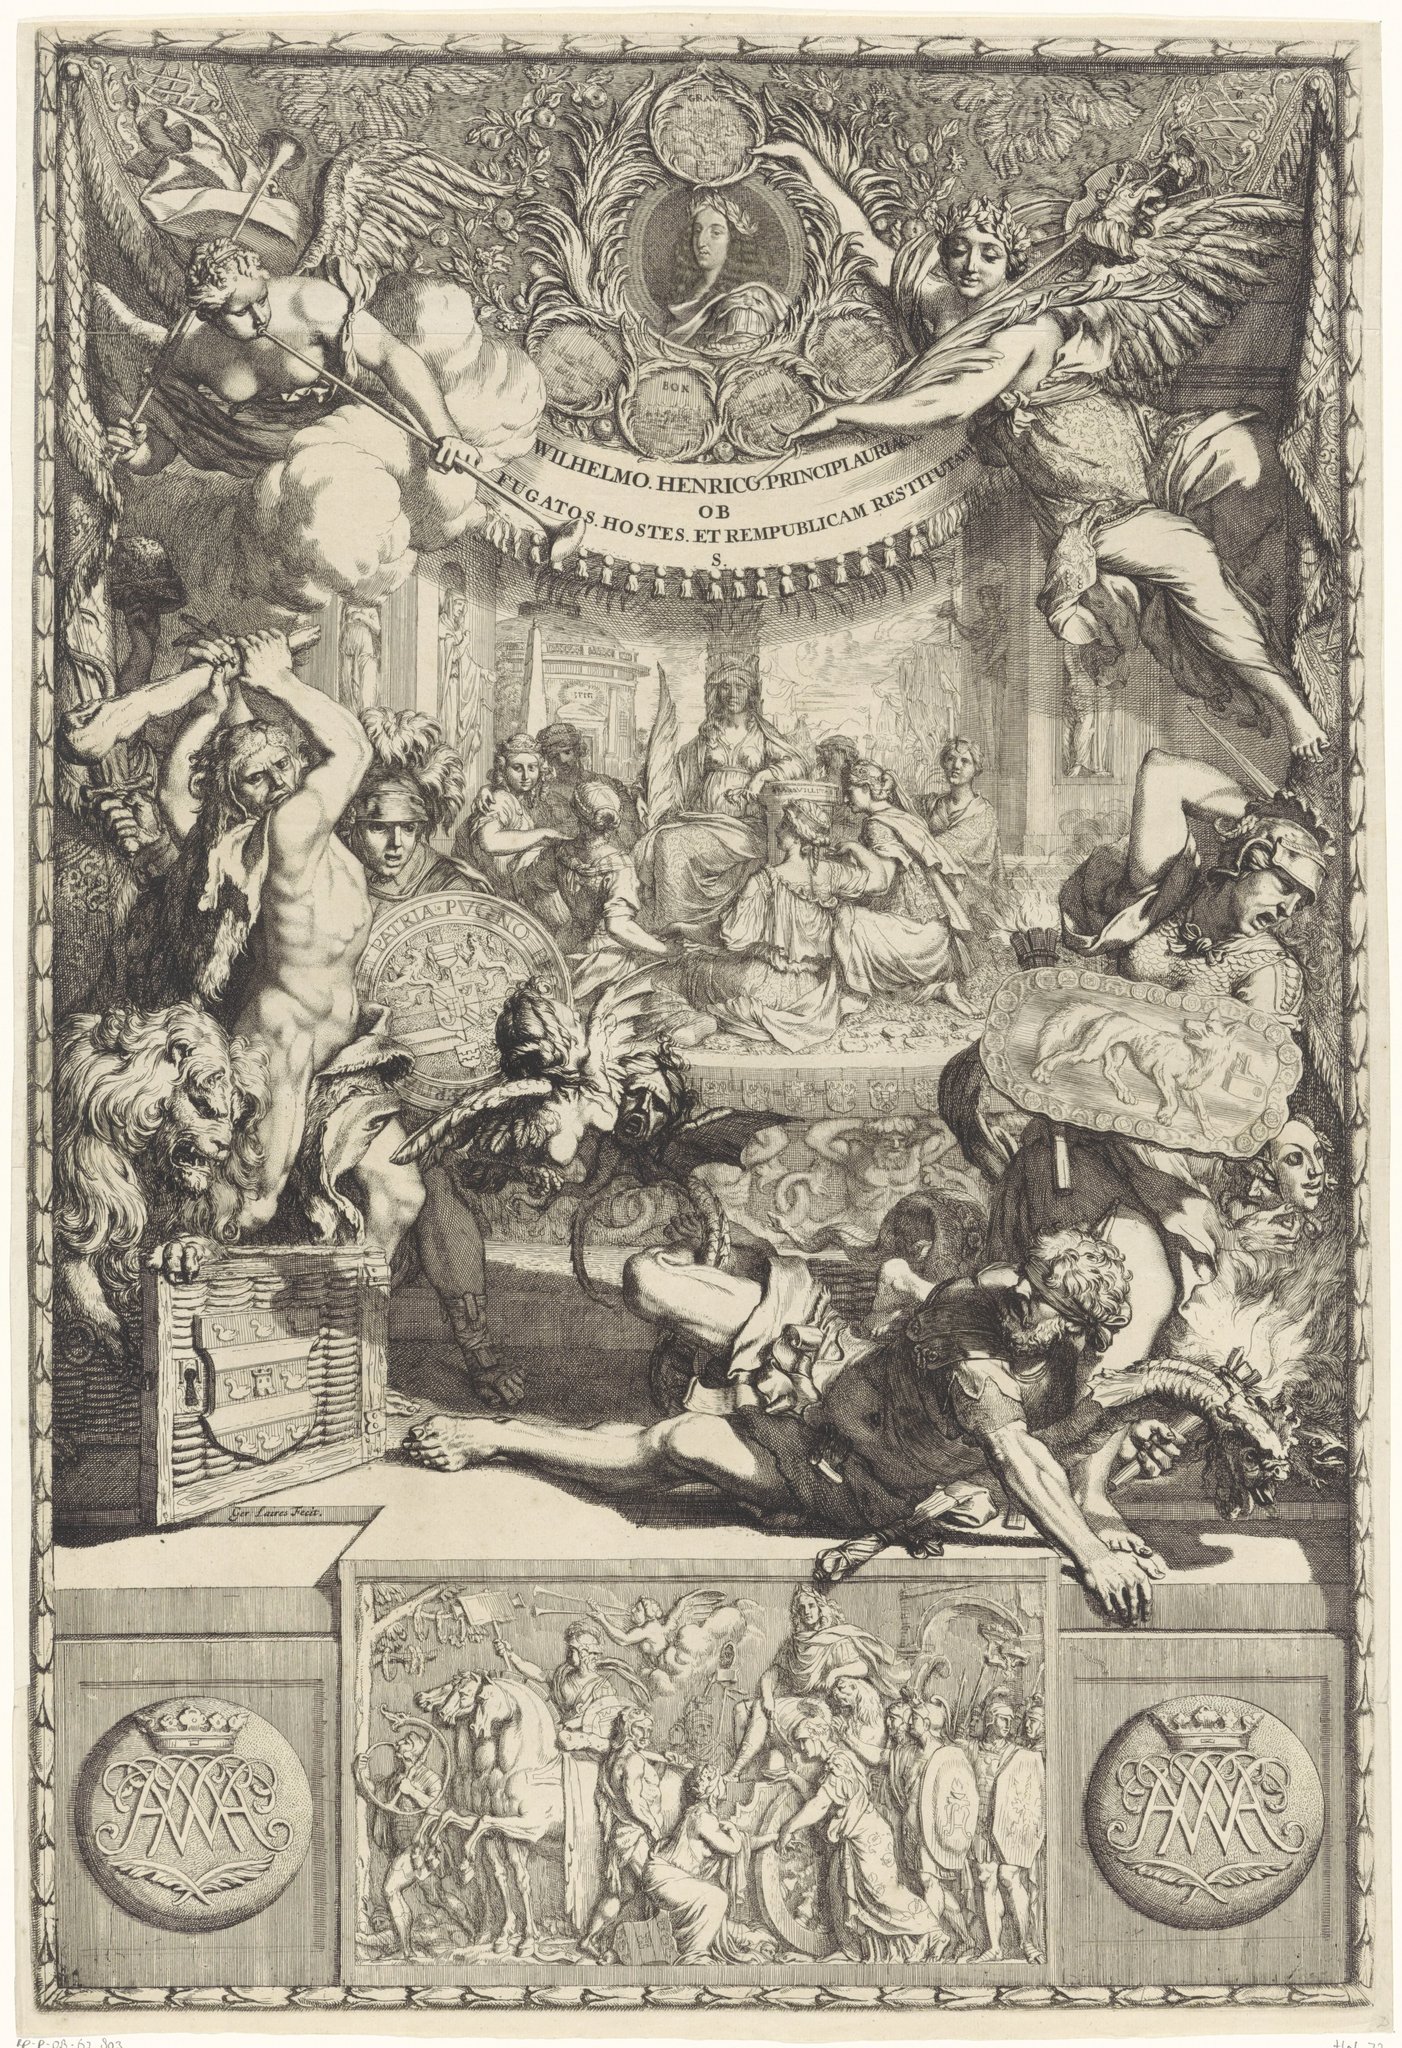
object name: print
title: Zinneprent op Willem III, na de veldtocht van 1673 en de verovering van Grave in 1674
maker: gerard de lairesse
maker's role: draughtsman, painter, print maker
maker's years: 1641-1711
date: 1674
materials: paper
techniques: etching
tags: the hague, william iii (prince of orange and king of england, scotland, and ireland), personifications of countries, nations, states, districts, etc. (+ province; provincial), (story of) hercules (heracles), political propaganda, lion's den (+ animals used symbolically), fenced or walled garden; 'hortus conclusus', conqueror triumphing, triumphal entry of victor, disagreement, discord; 'discordia' (ripa), fame; 'fama', 'fama buona', 'fama chiara' (ripa), grave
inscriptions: collector's mark: Lugt 240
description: Grote allegorische voorstelling op de militaire successen van Willem III en de verovering van Grave, 26 oktober 1674. Bovenaan wordt Willem III gekroond door de Overwinning en wordt Grave toegevoegd aan de reeks van zijn overwinningen. De Faam blaast op een bazuin. Op de voorgrond verjagen Hercules en de Nederlandse Leeuw de Oorlog en de Tweedracht uit de Hollandse Tuin, het wapen van Grave staat op het hek. Op de achtergrond de provinciemaagden. Onderaan een fries met een Romeinse triomfoptocht en het monogram van de prins.